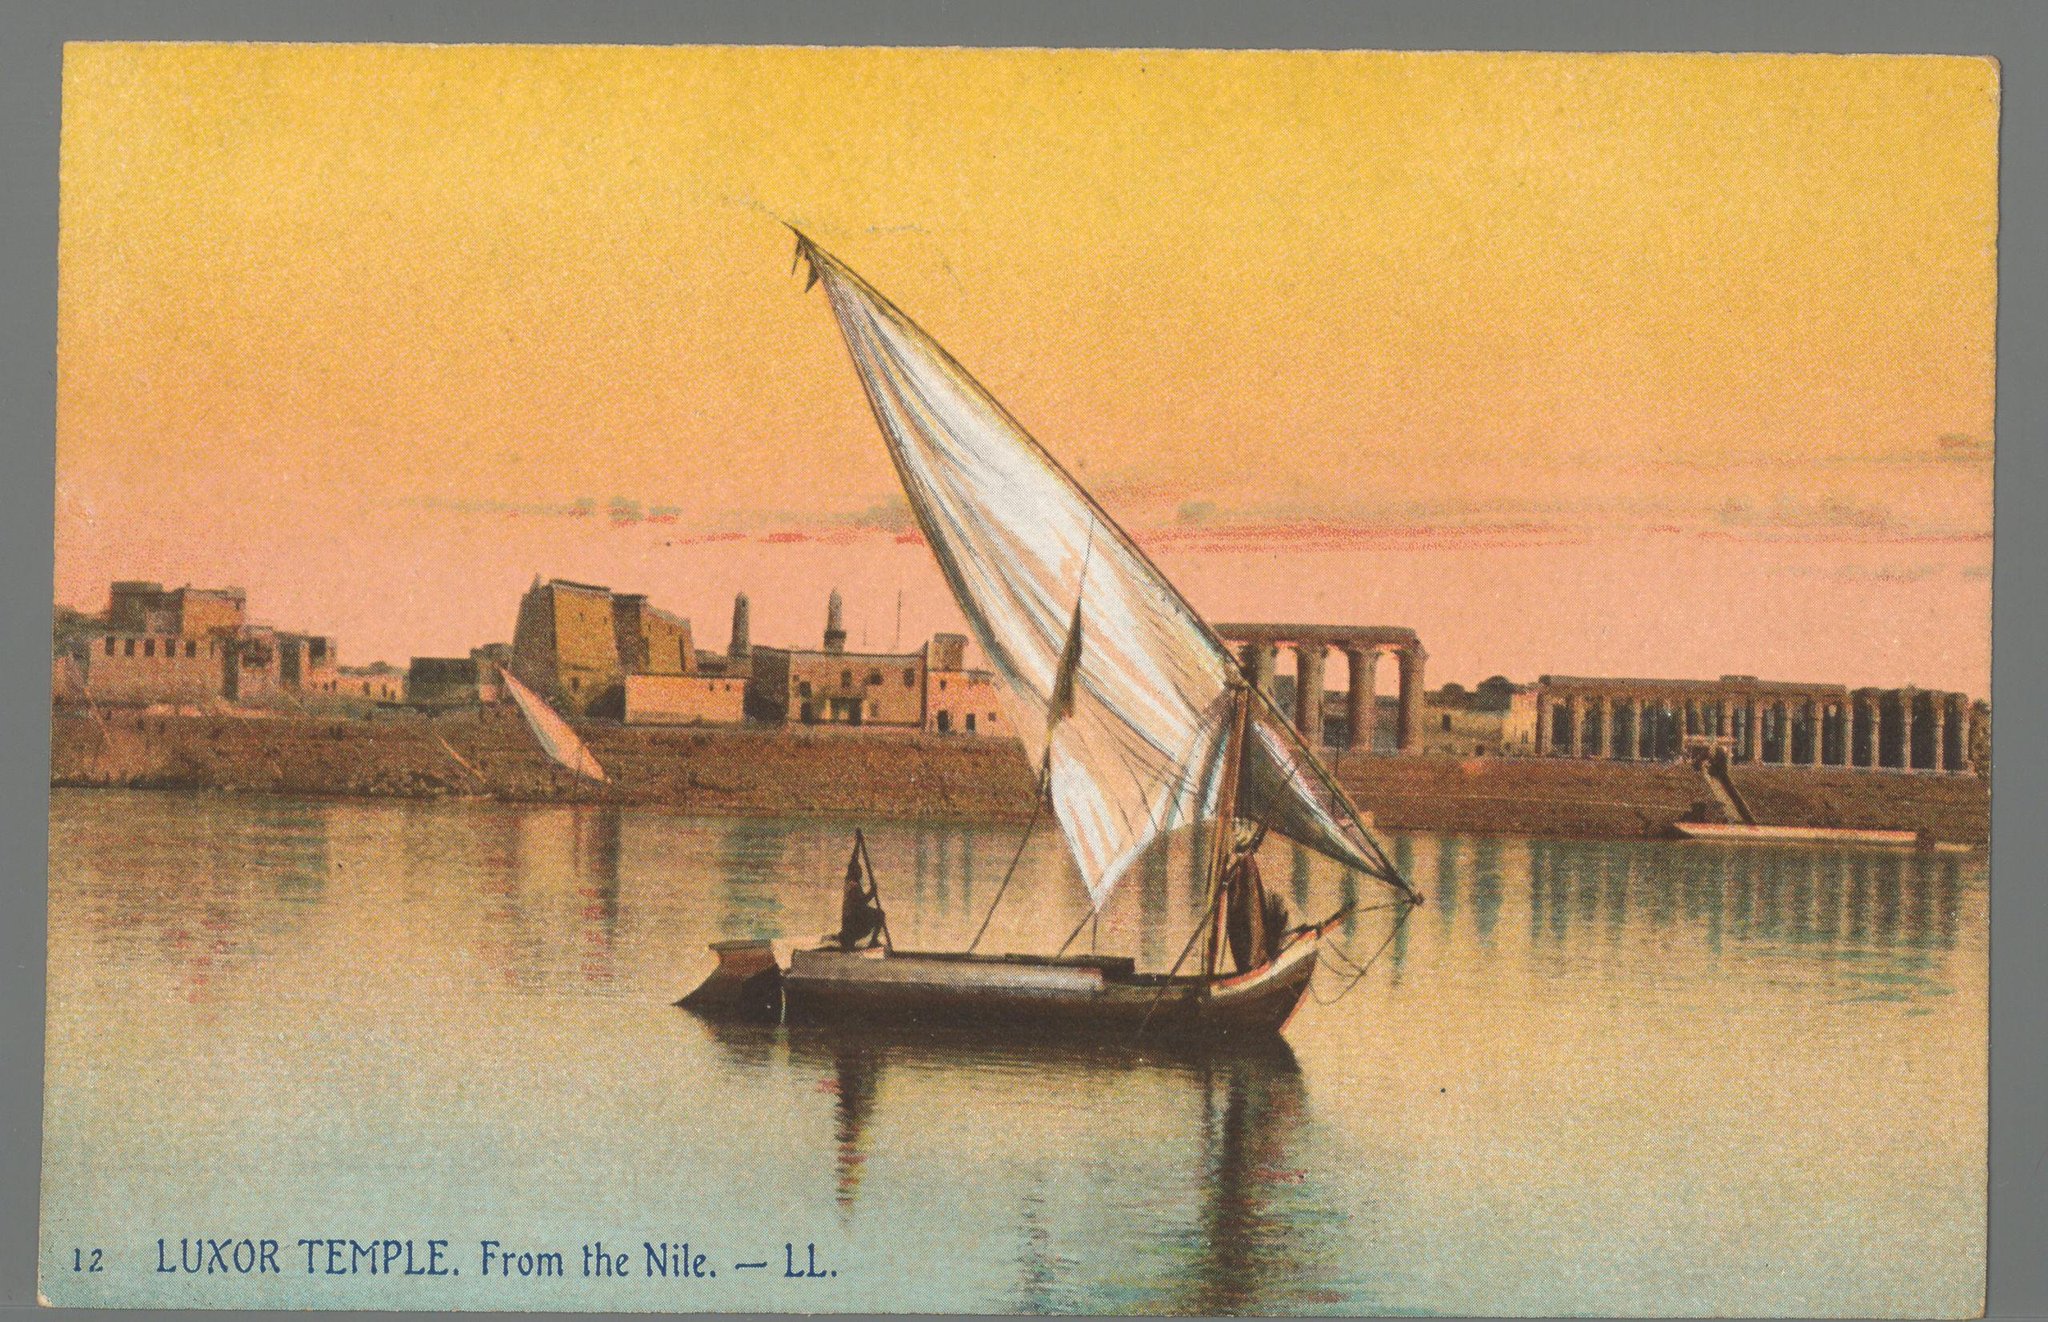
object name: photomechanical print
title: Luxor Temple - From the Nile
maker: Anonymous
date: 1907-1930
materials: cardboard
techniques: lithograph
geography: luxor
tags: temple, shrine ~ egyptian religion, river